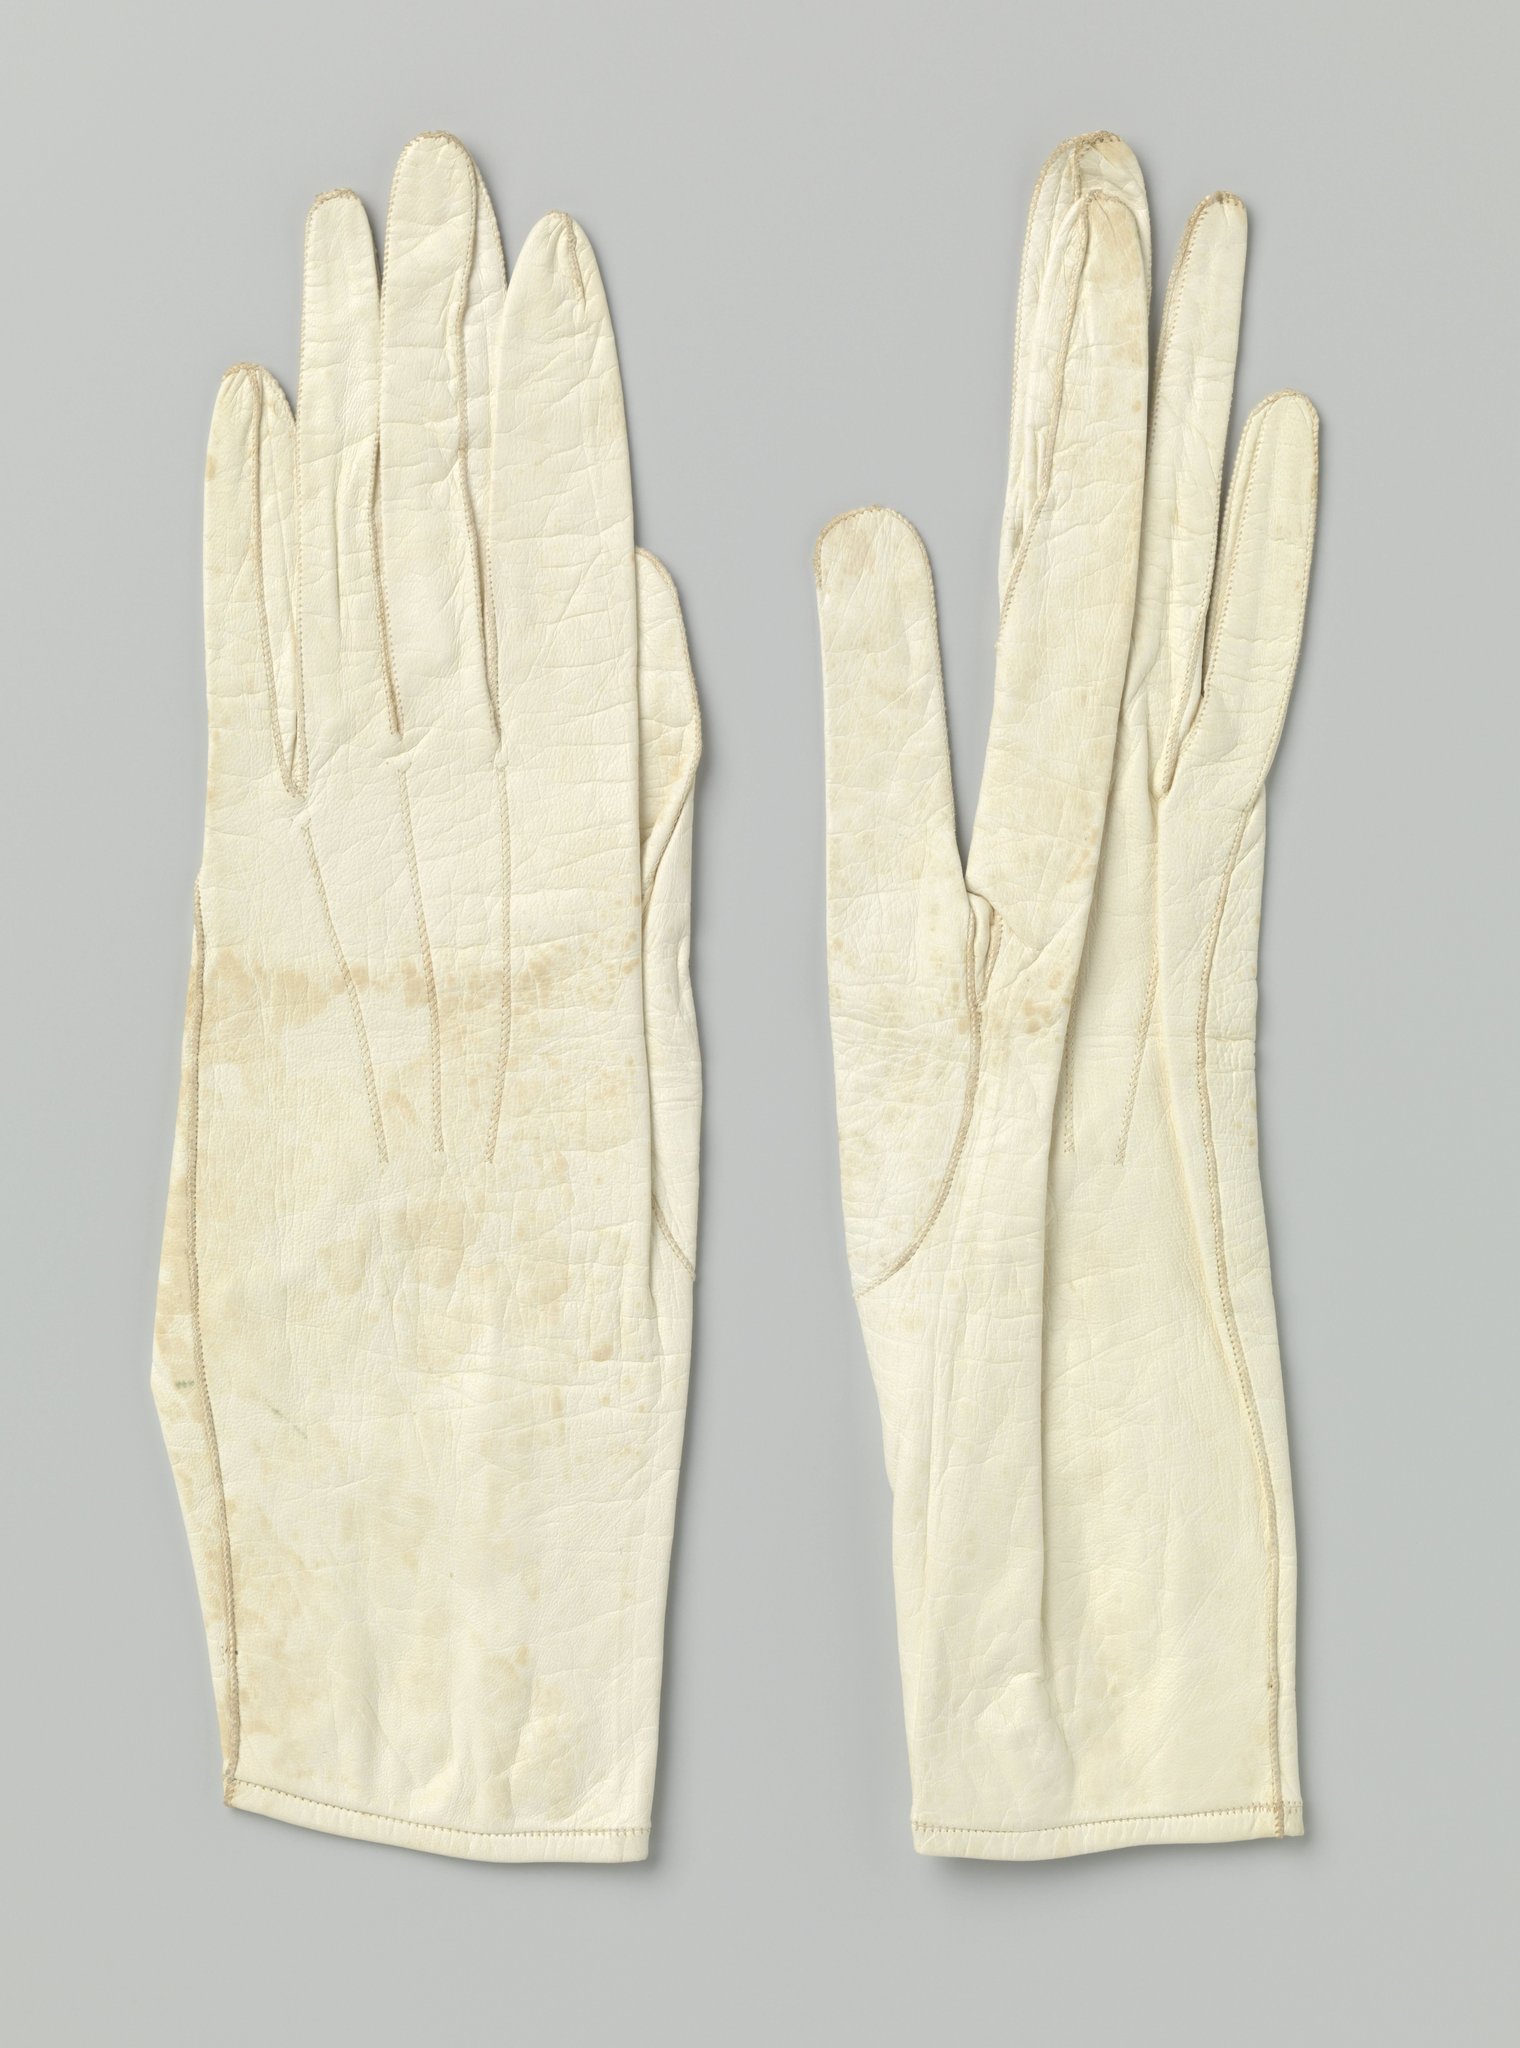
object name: womenswear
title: Handschoen van glacéleer, kort model, sluiting met drie knopen van parelmoer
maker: m. laimböck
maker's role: modehuis, modewarenhuis, modewinkel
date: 1900-1925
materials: mother of pearl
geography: netherlands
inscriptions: stamp: ‘tekst’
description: Rechter handschoen van glacéleer. Bij de pols een split met drie parelmoeren knoopjes. Op de hand drie gestikte lijnen.